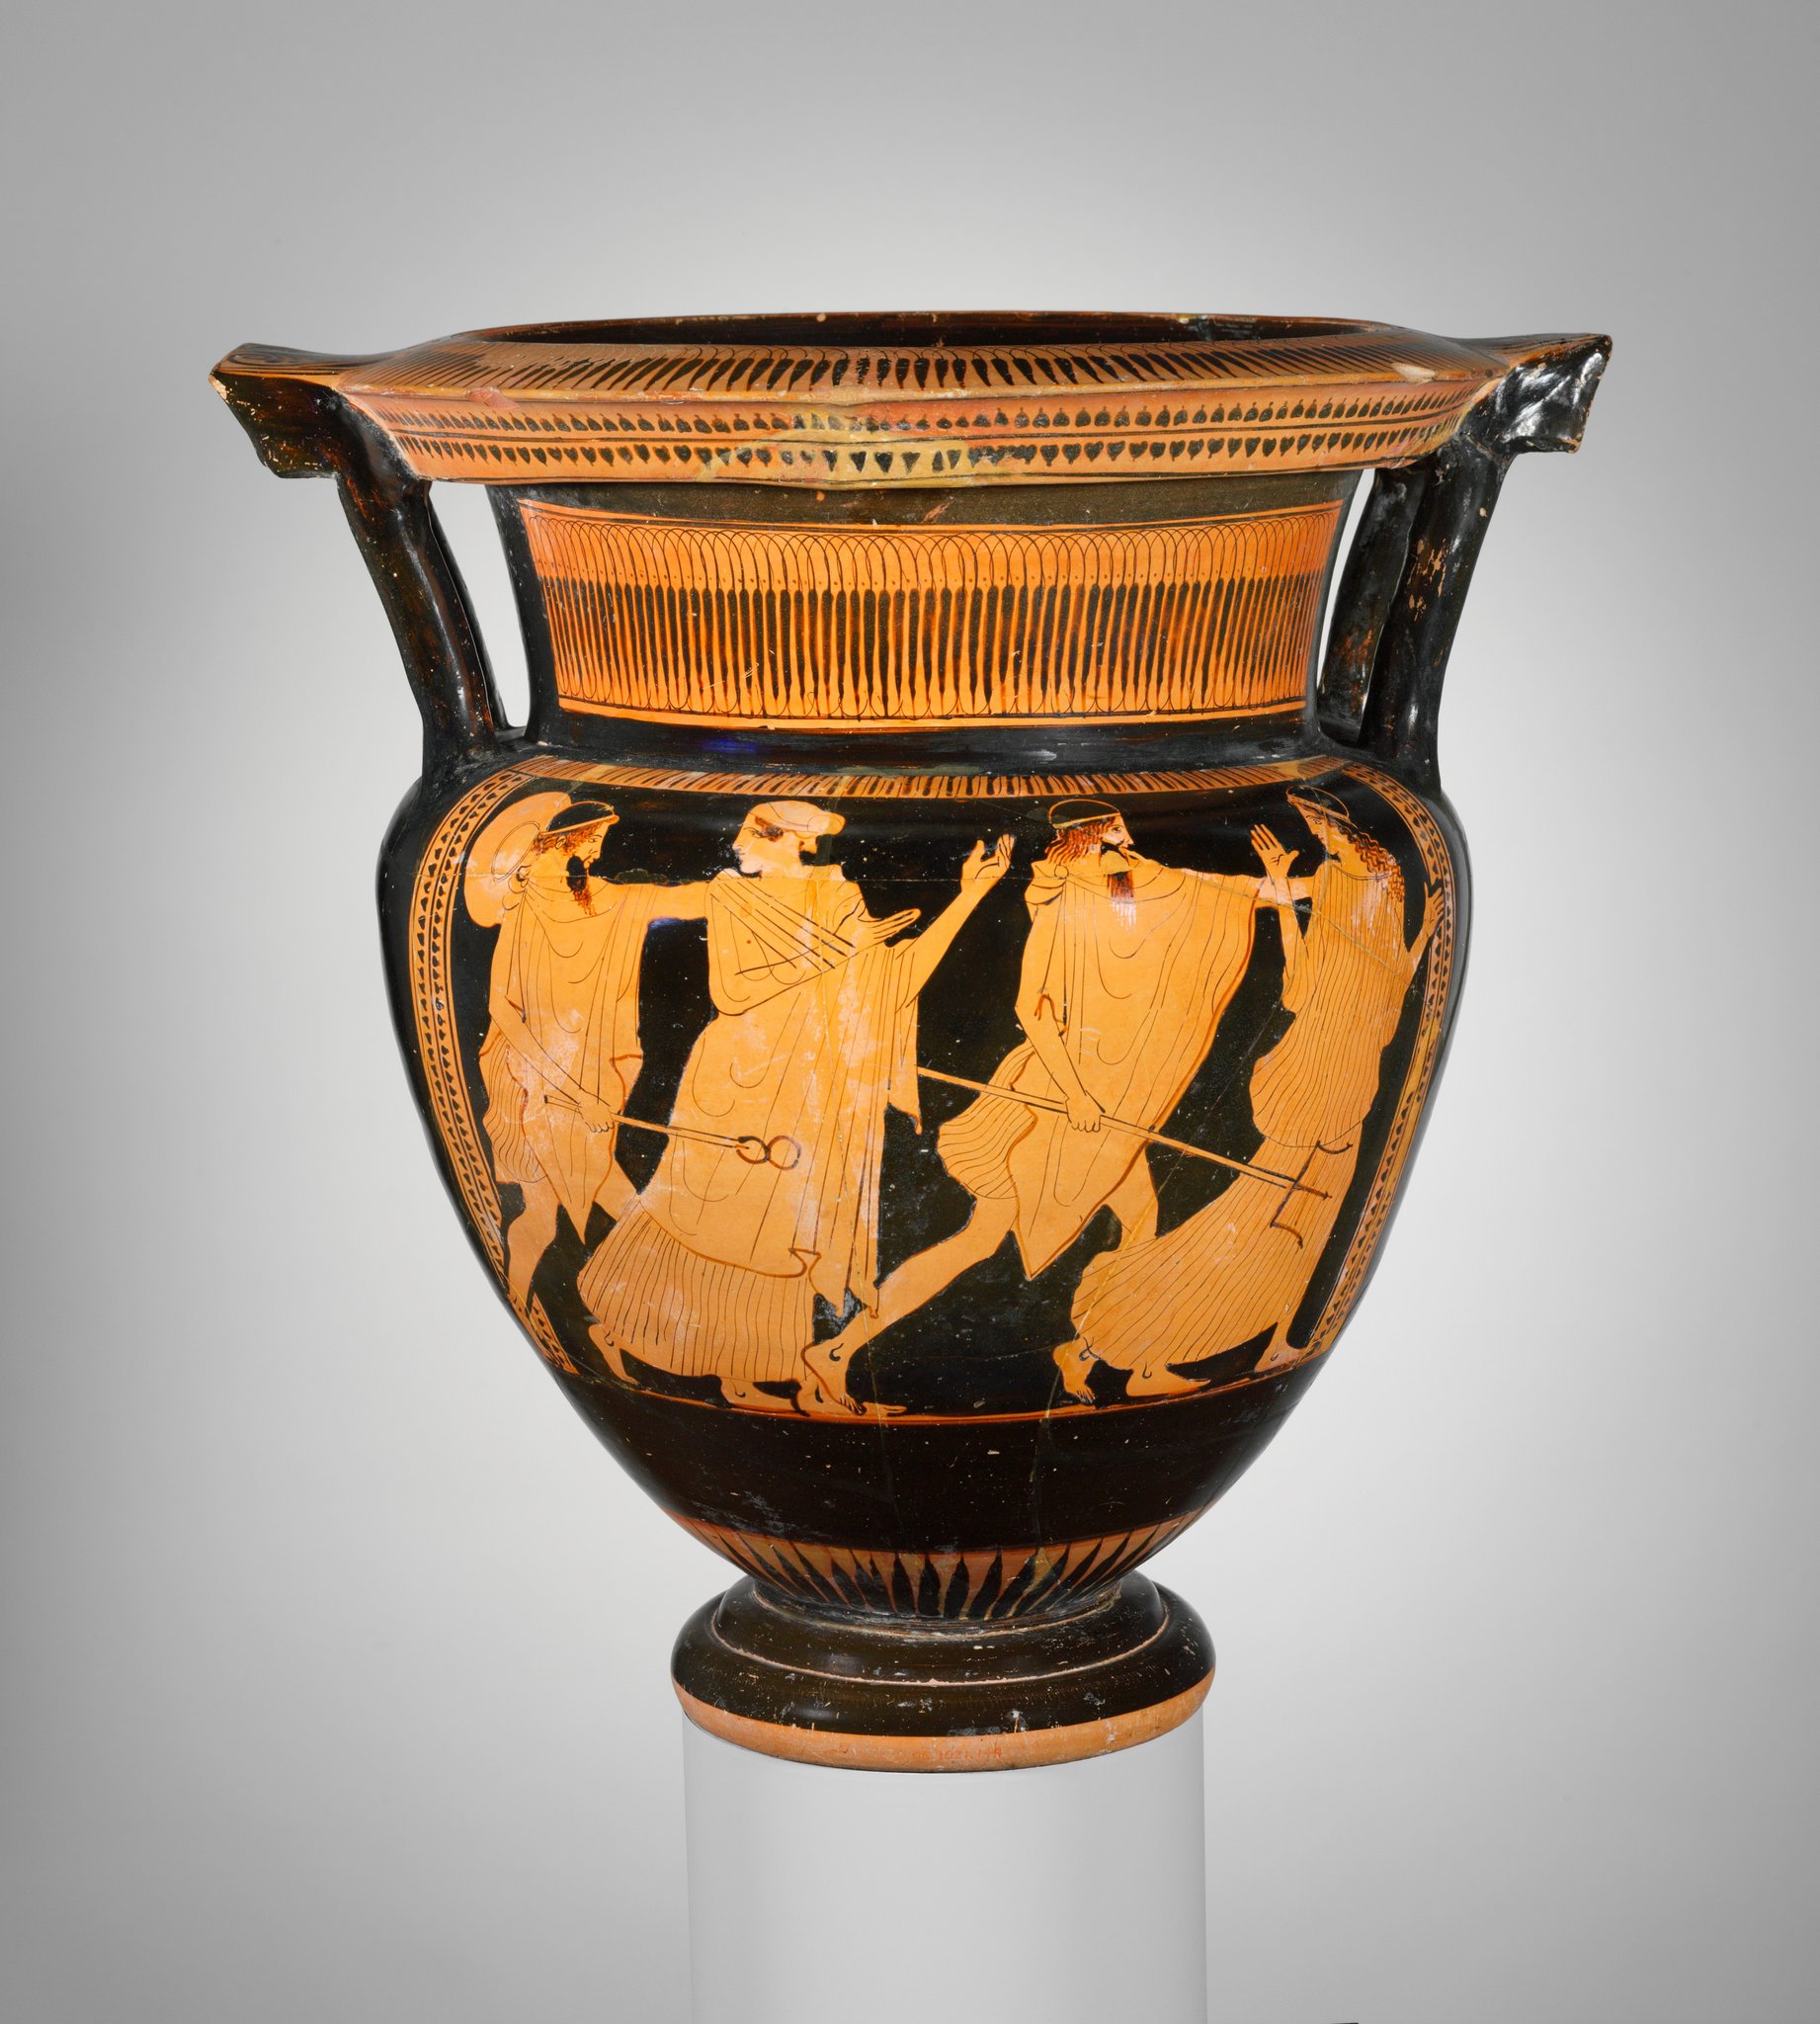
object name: column krater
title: Terracotta column-krater (bowl for mixing wine and water)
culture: greek, attic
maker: orchard painter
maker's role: artist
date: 460 BCE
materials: terracotta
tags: women,hermes,poseidon